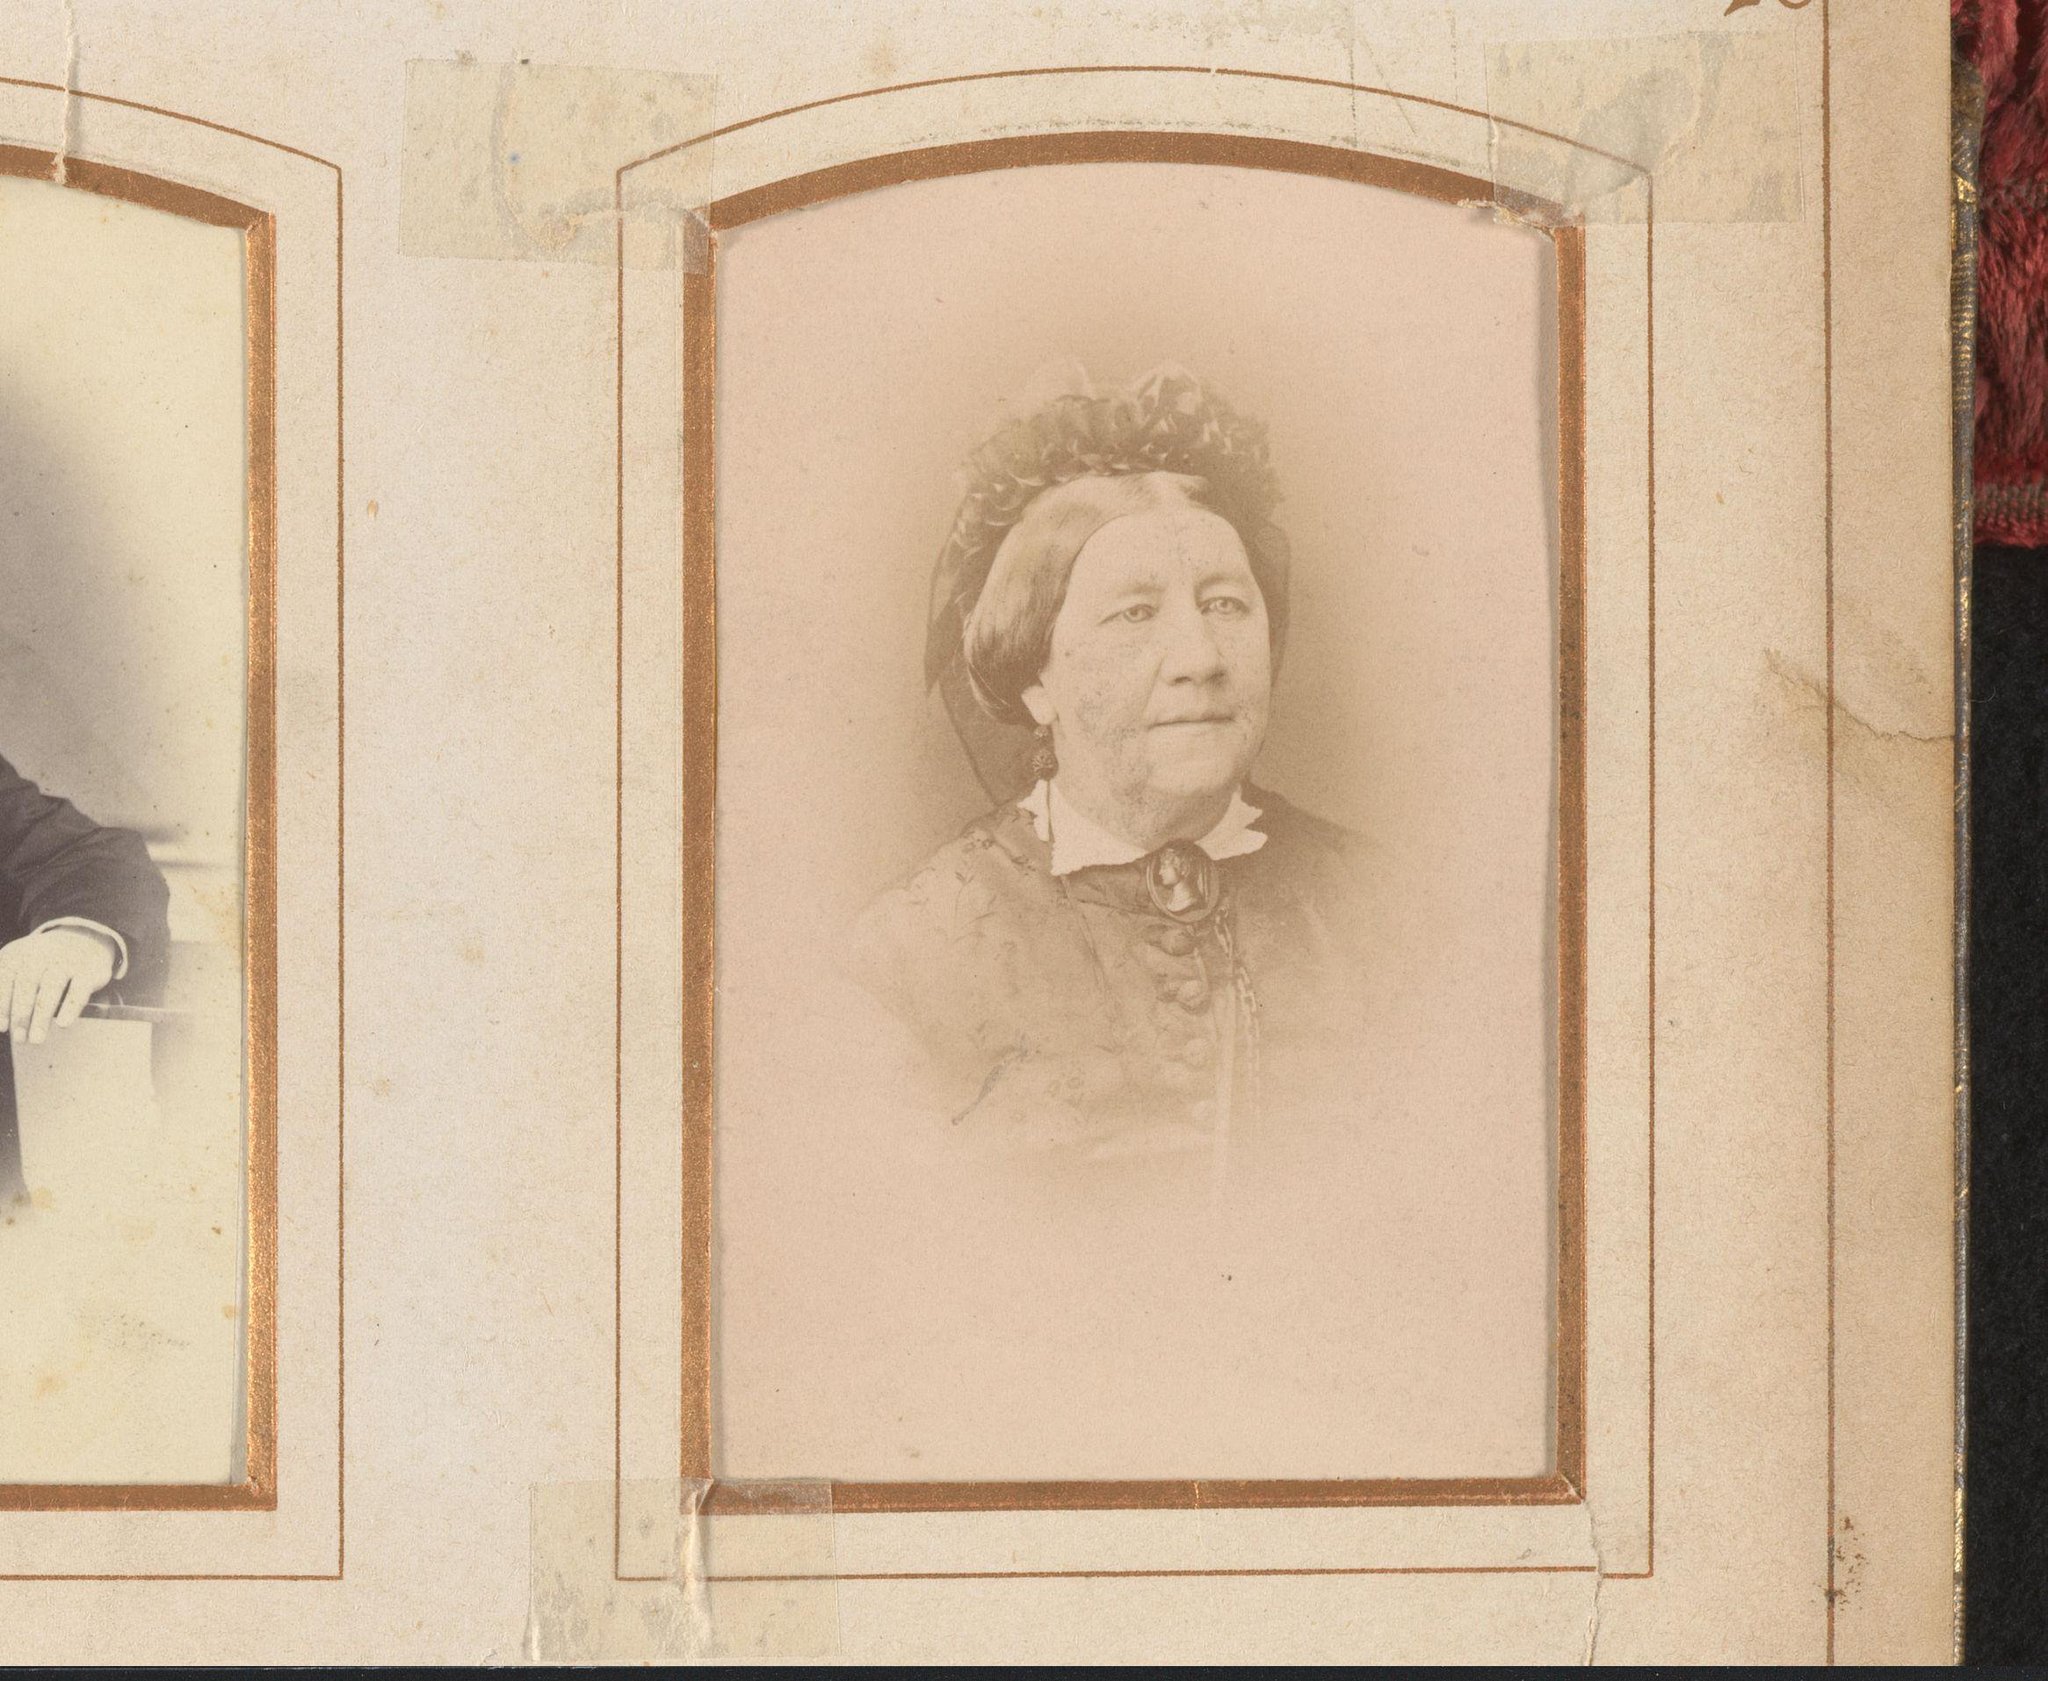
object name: carte de visite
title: Portret van een vrouw met muts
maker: Anonymous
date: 1860-1900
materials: cardboard, photographic support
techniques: albumen print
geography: sweden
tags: historical persons - bb - woman, head-gear: cap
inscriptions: annotation: ‘Zweeds’